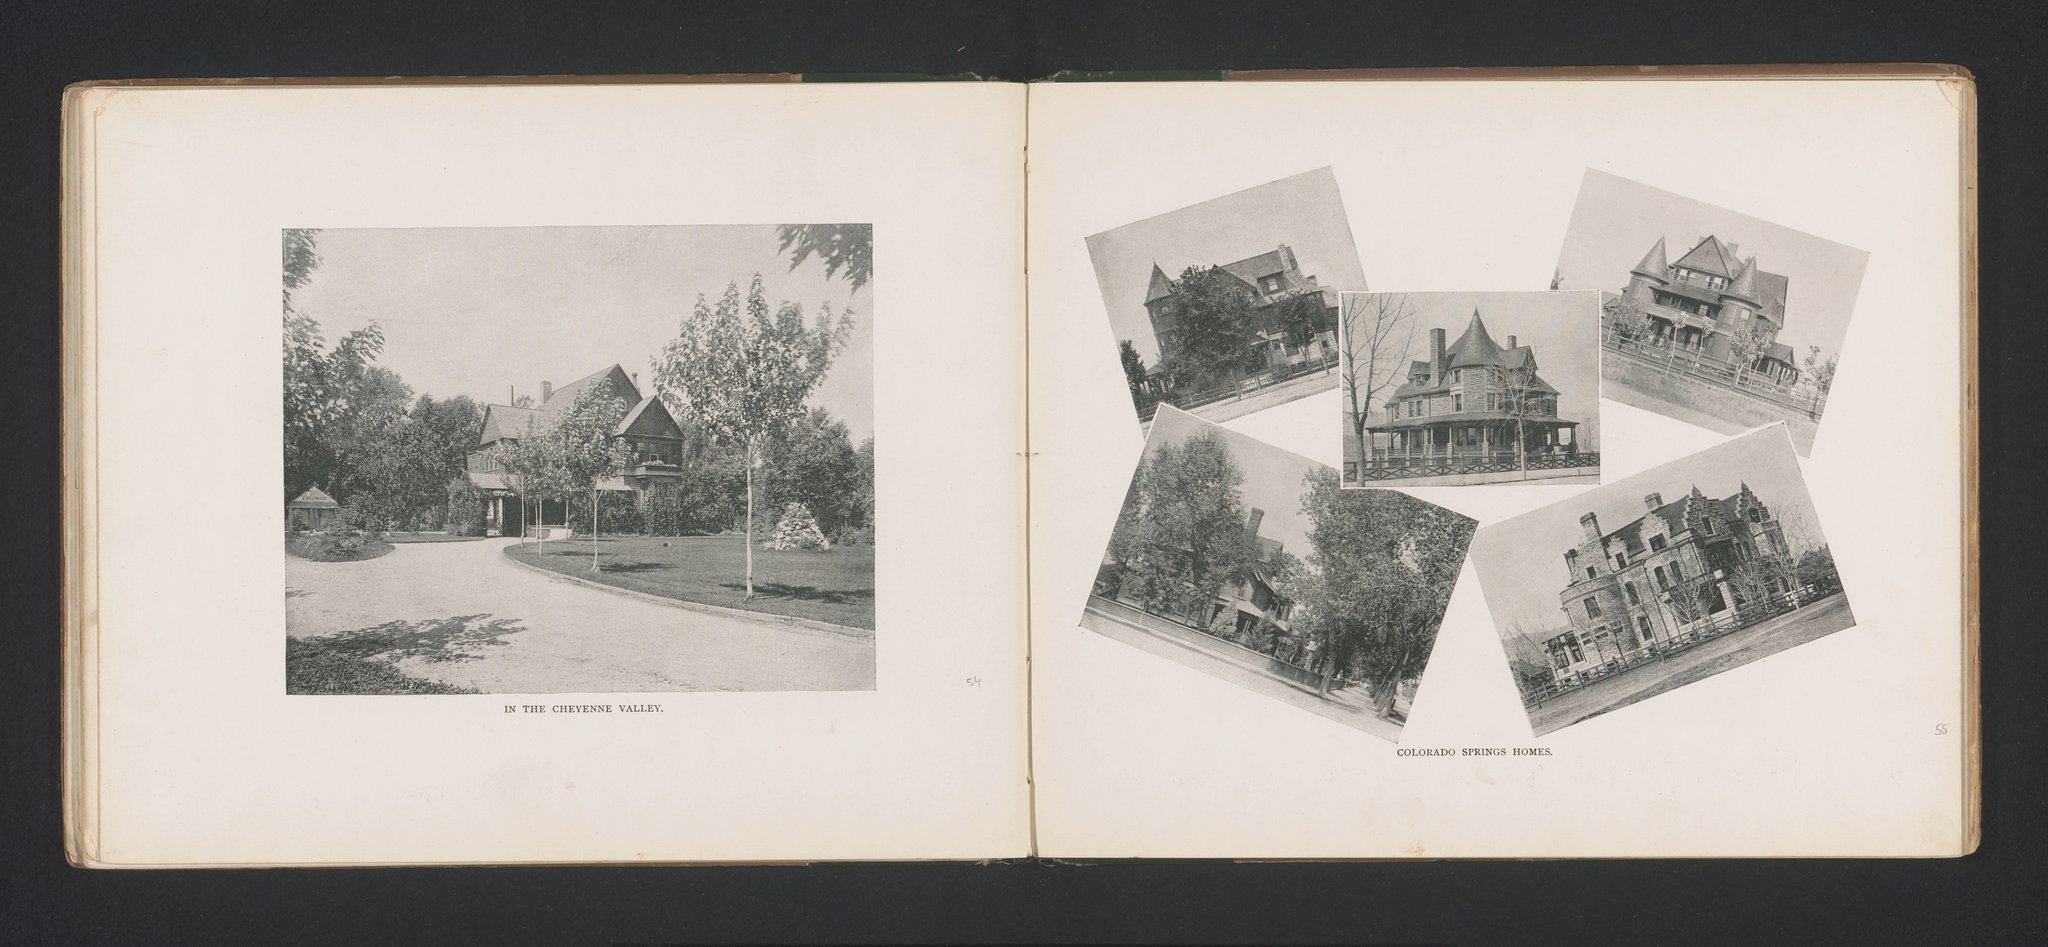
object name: photomechanical print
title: In the Cheyenne Valley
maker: Anonymous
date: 1888-1893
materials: paper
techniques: autotype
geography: colorado springs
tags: villa